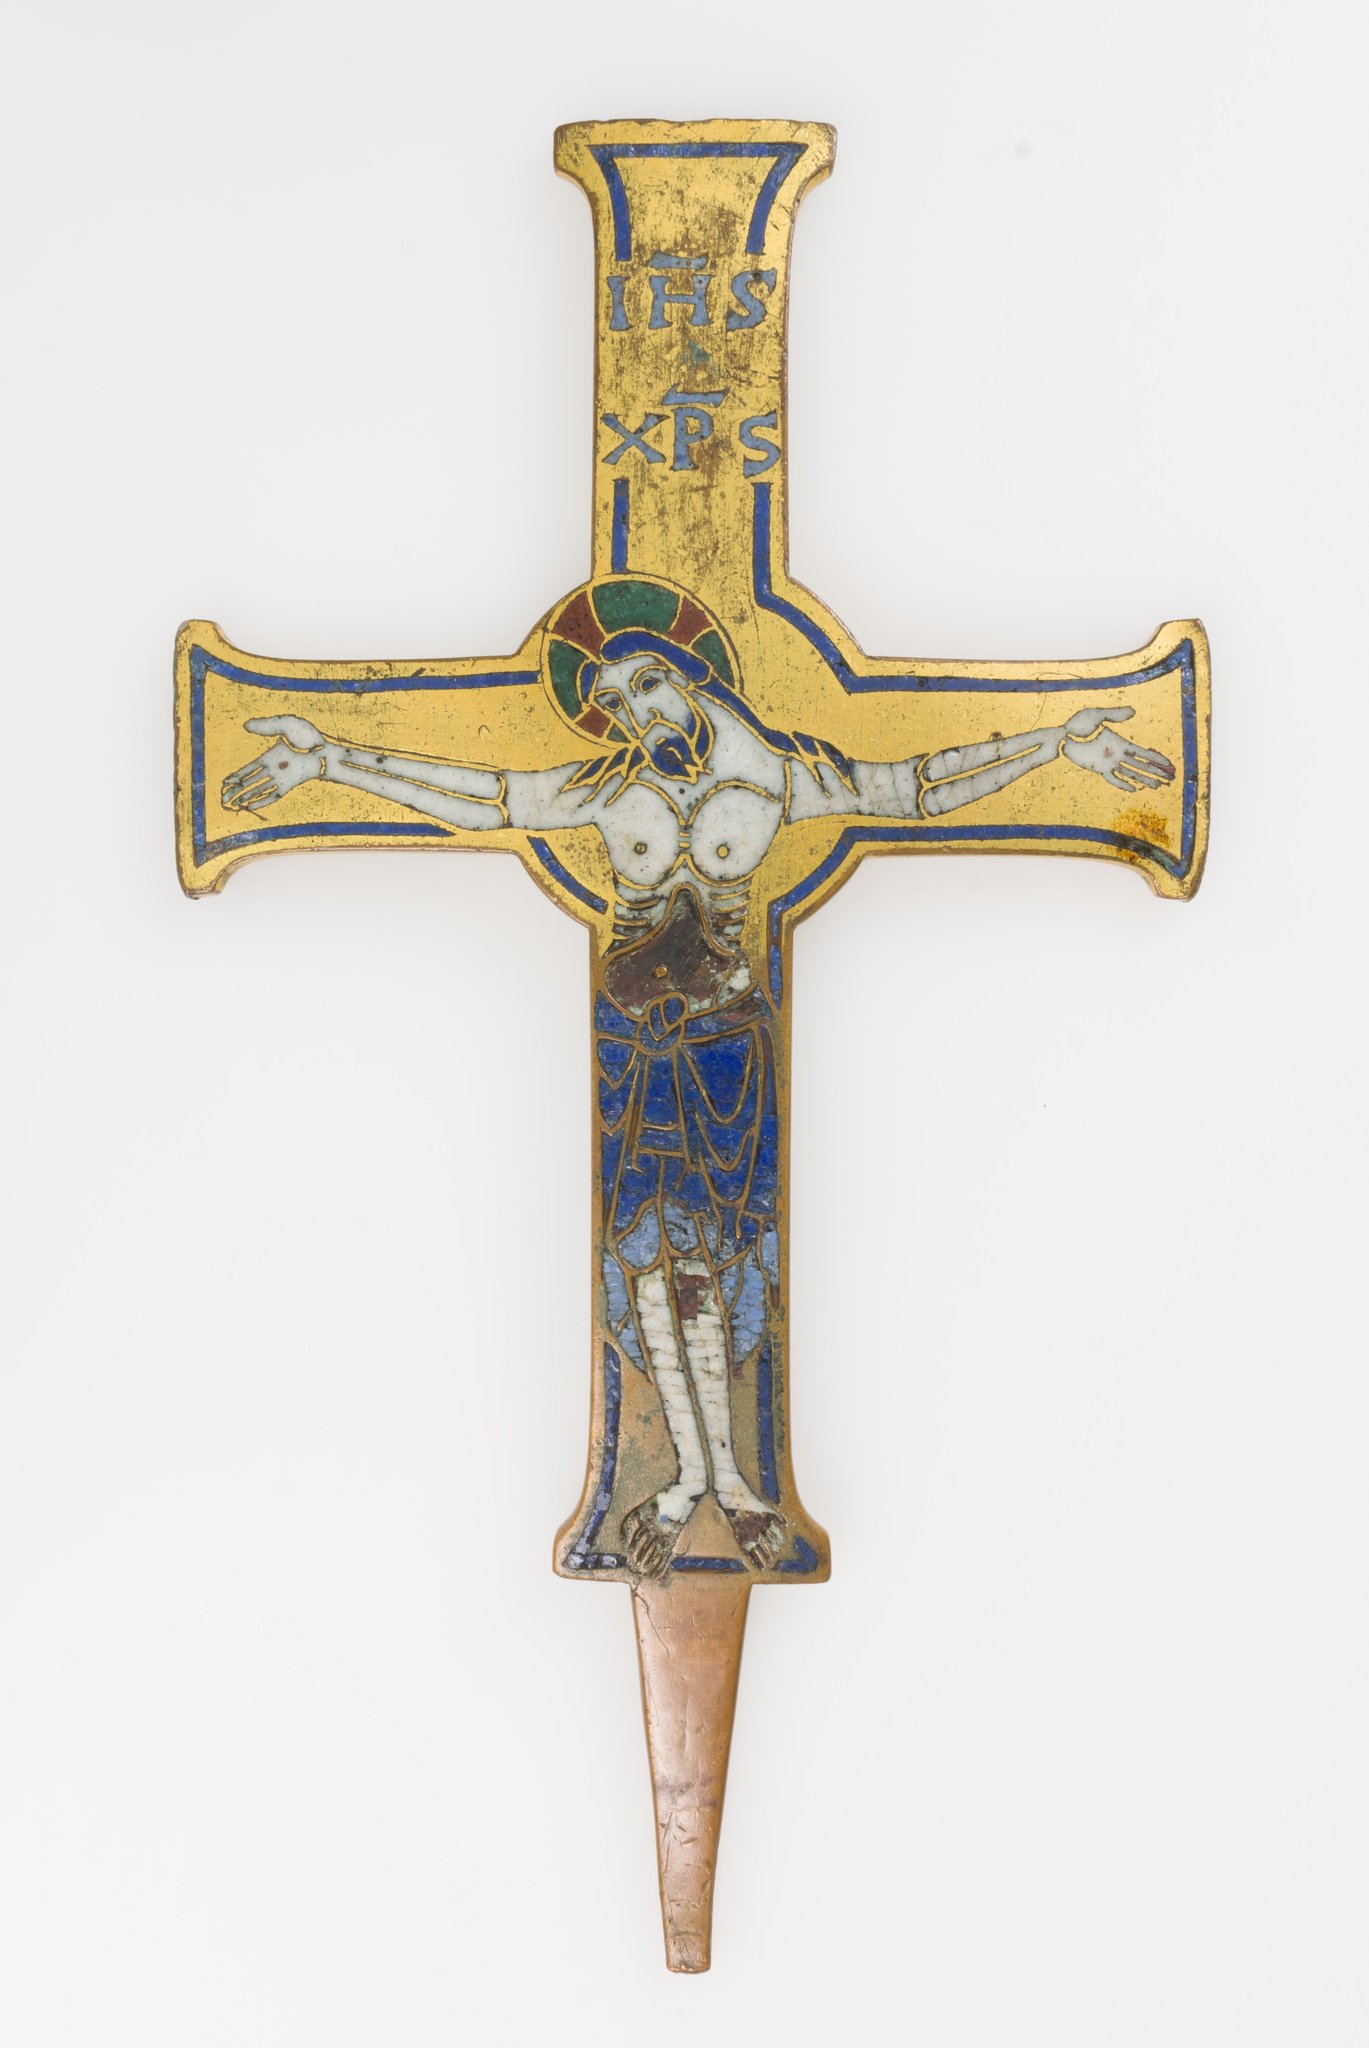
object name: cross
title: Crucifix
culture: spanish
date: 1150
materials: gilt copper, enamel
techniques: enamel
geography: spain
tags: christ